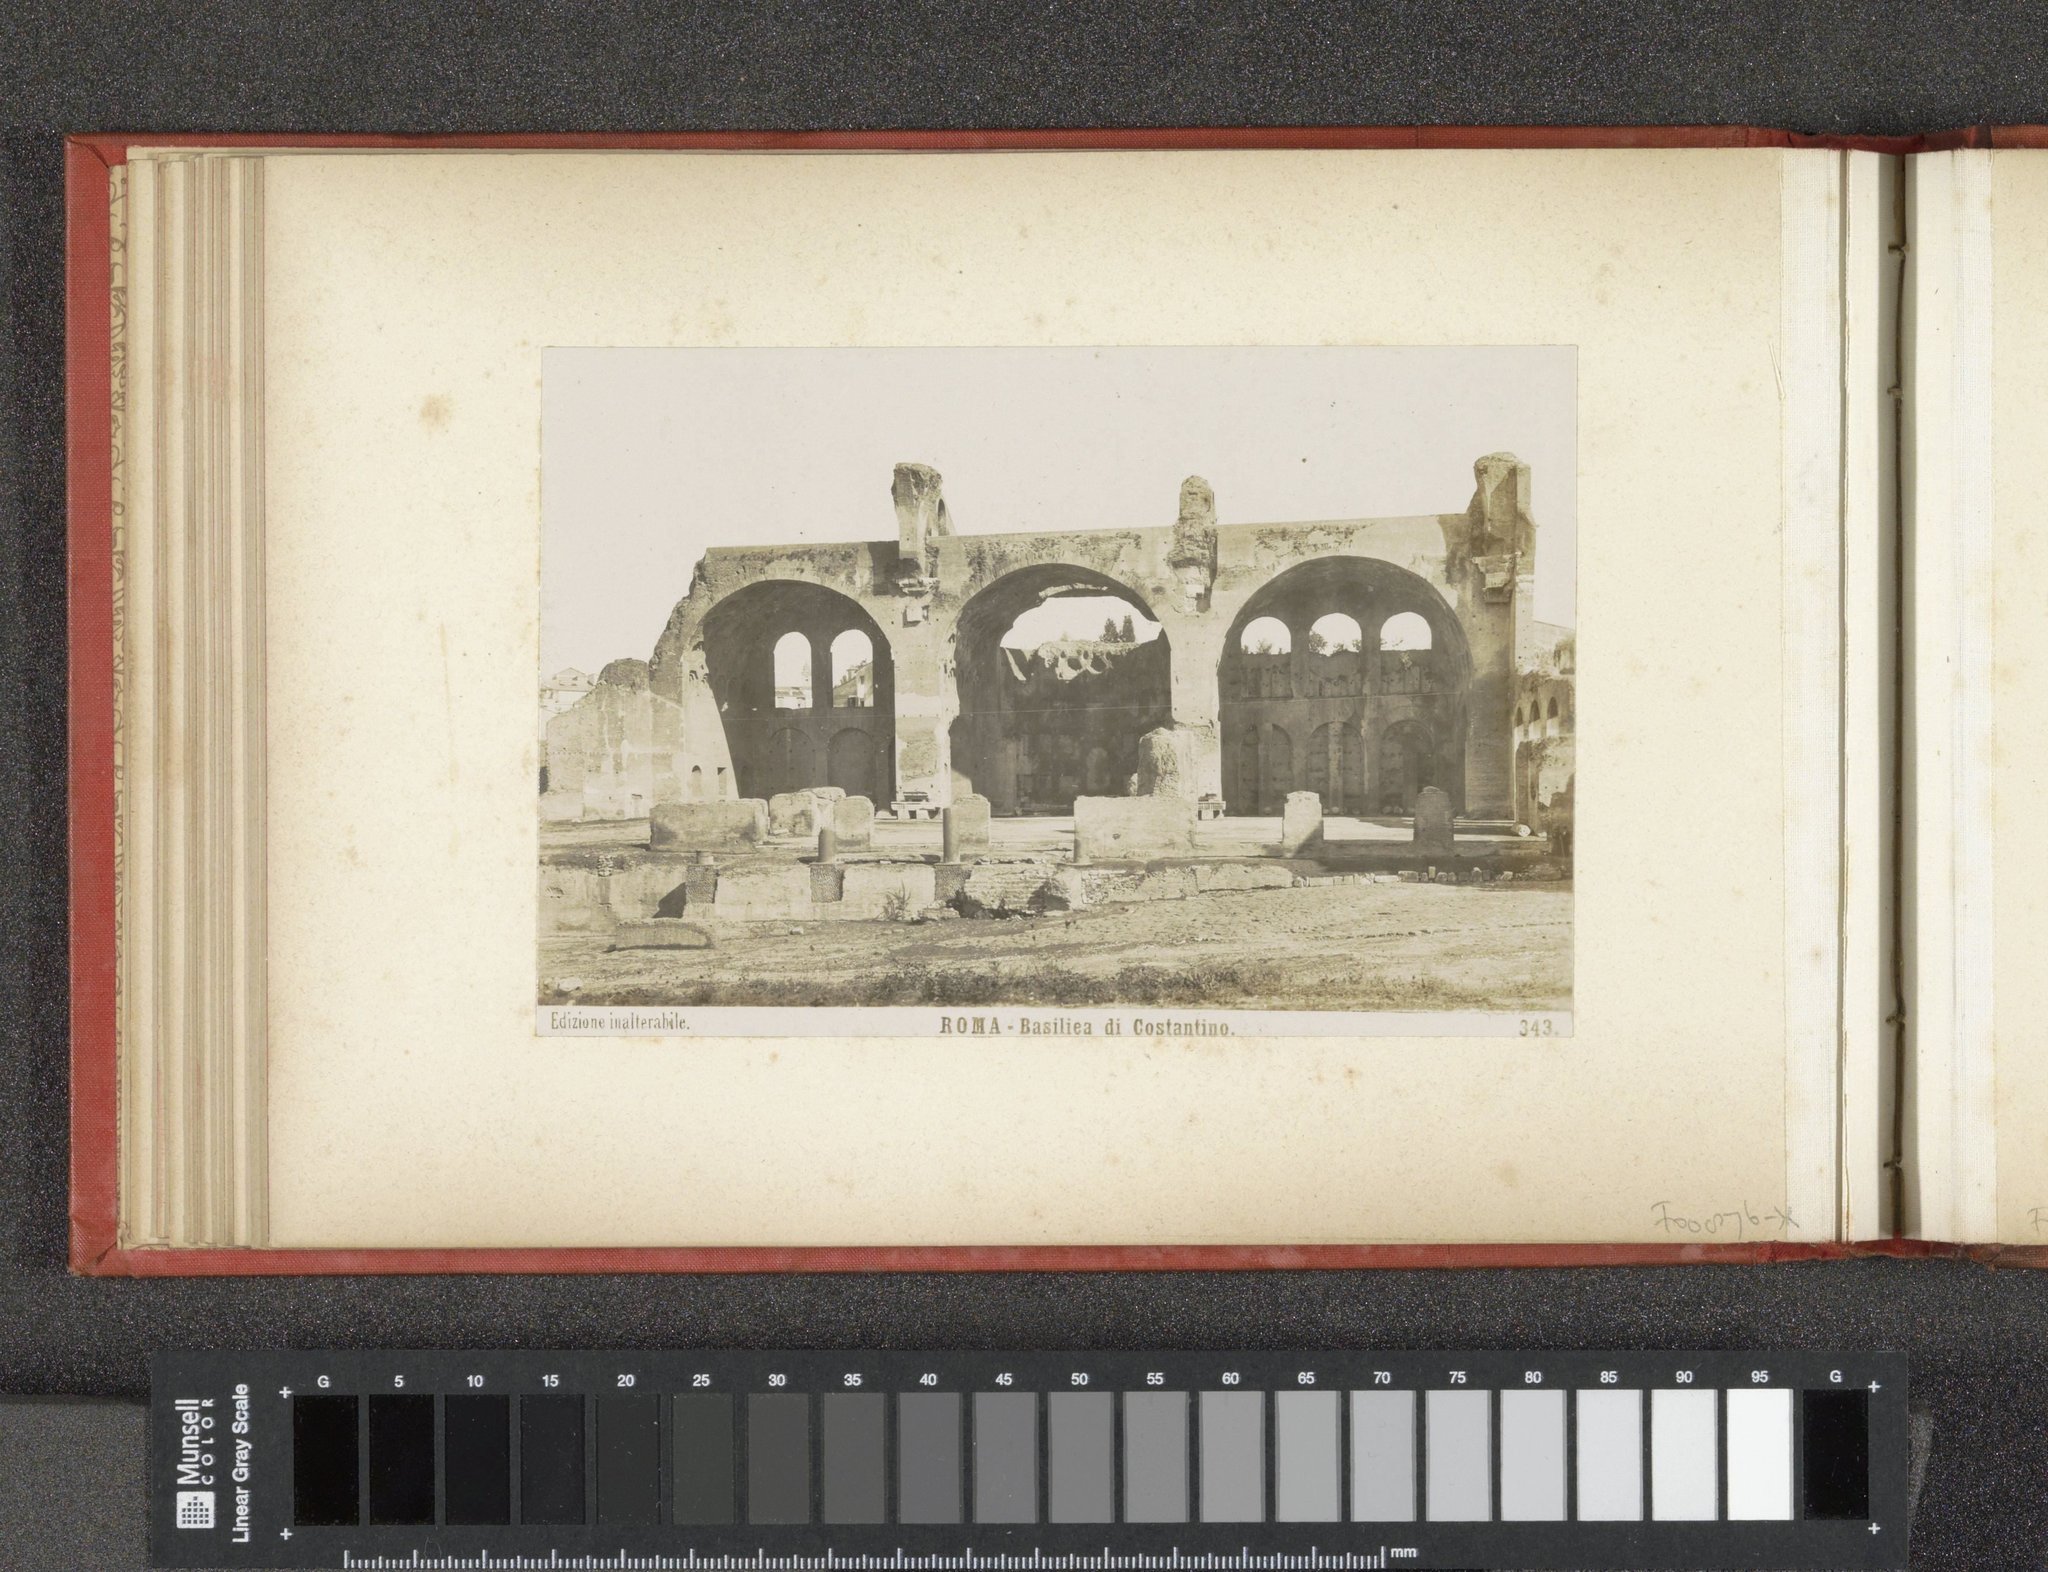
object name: photograph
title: ROMA - Basilica di Costantino.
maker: Anonymous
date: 1860-1890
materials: cardboard, photographic support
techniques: gelatin silver print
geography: rome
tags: ruin of a building ~ architecture, prospect of city, town panorama, silhouette of city, rome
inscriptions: number: ‘343’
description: Onderdeel van Fotoalbum met opnames van kerken, beelden en antieke gebouwen in Rome.